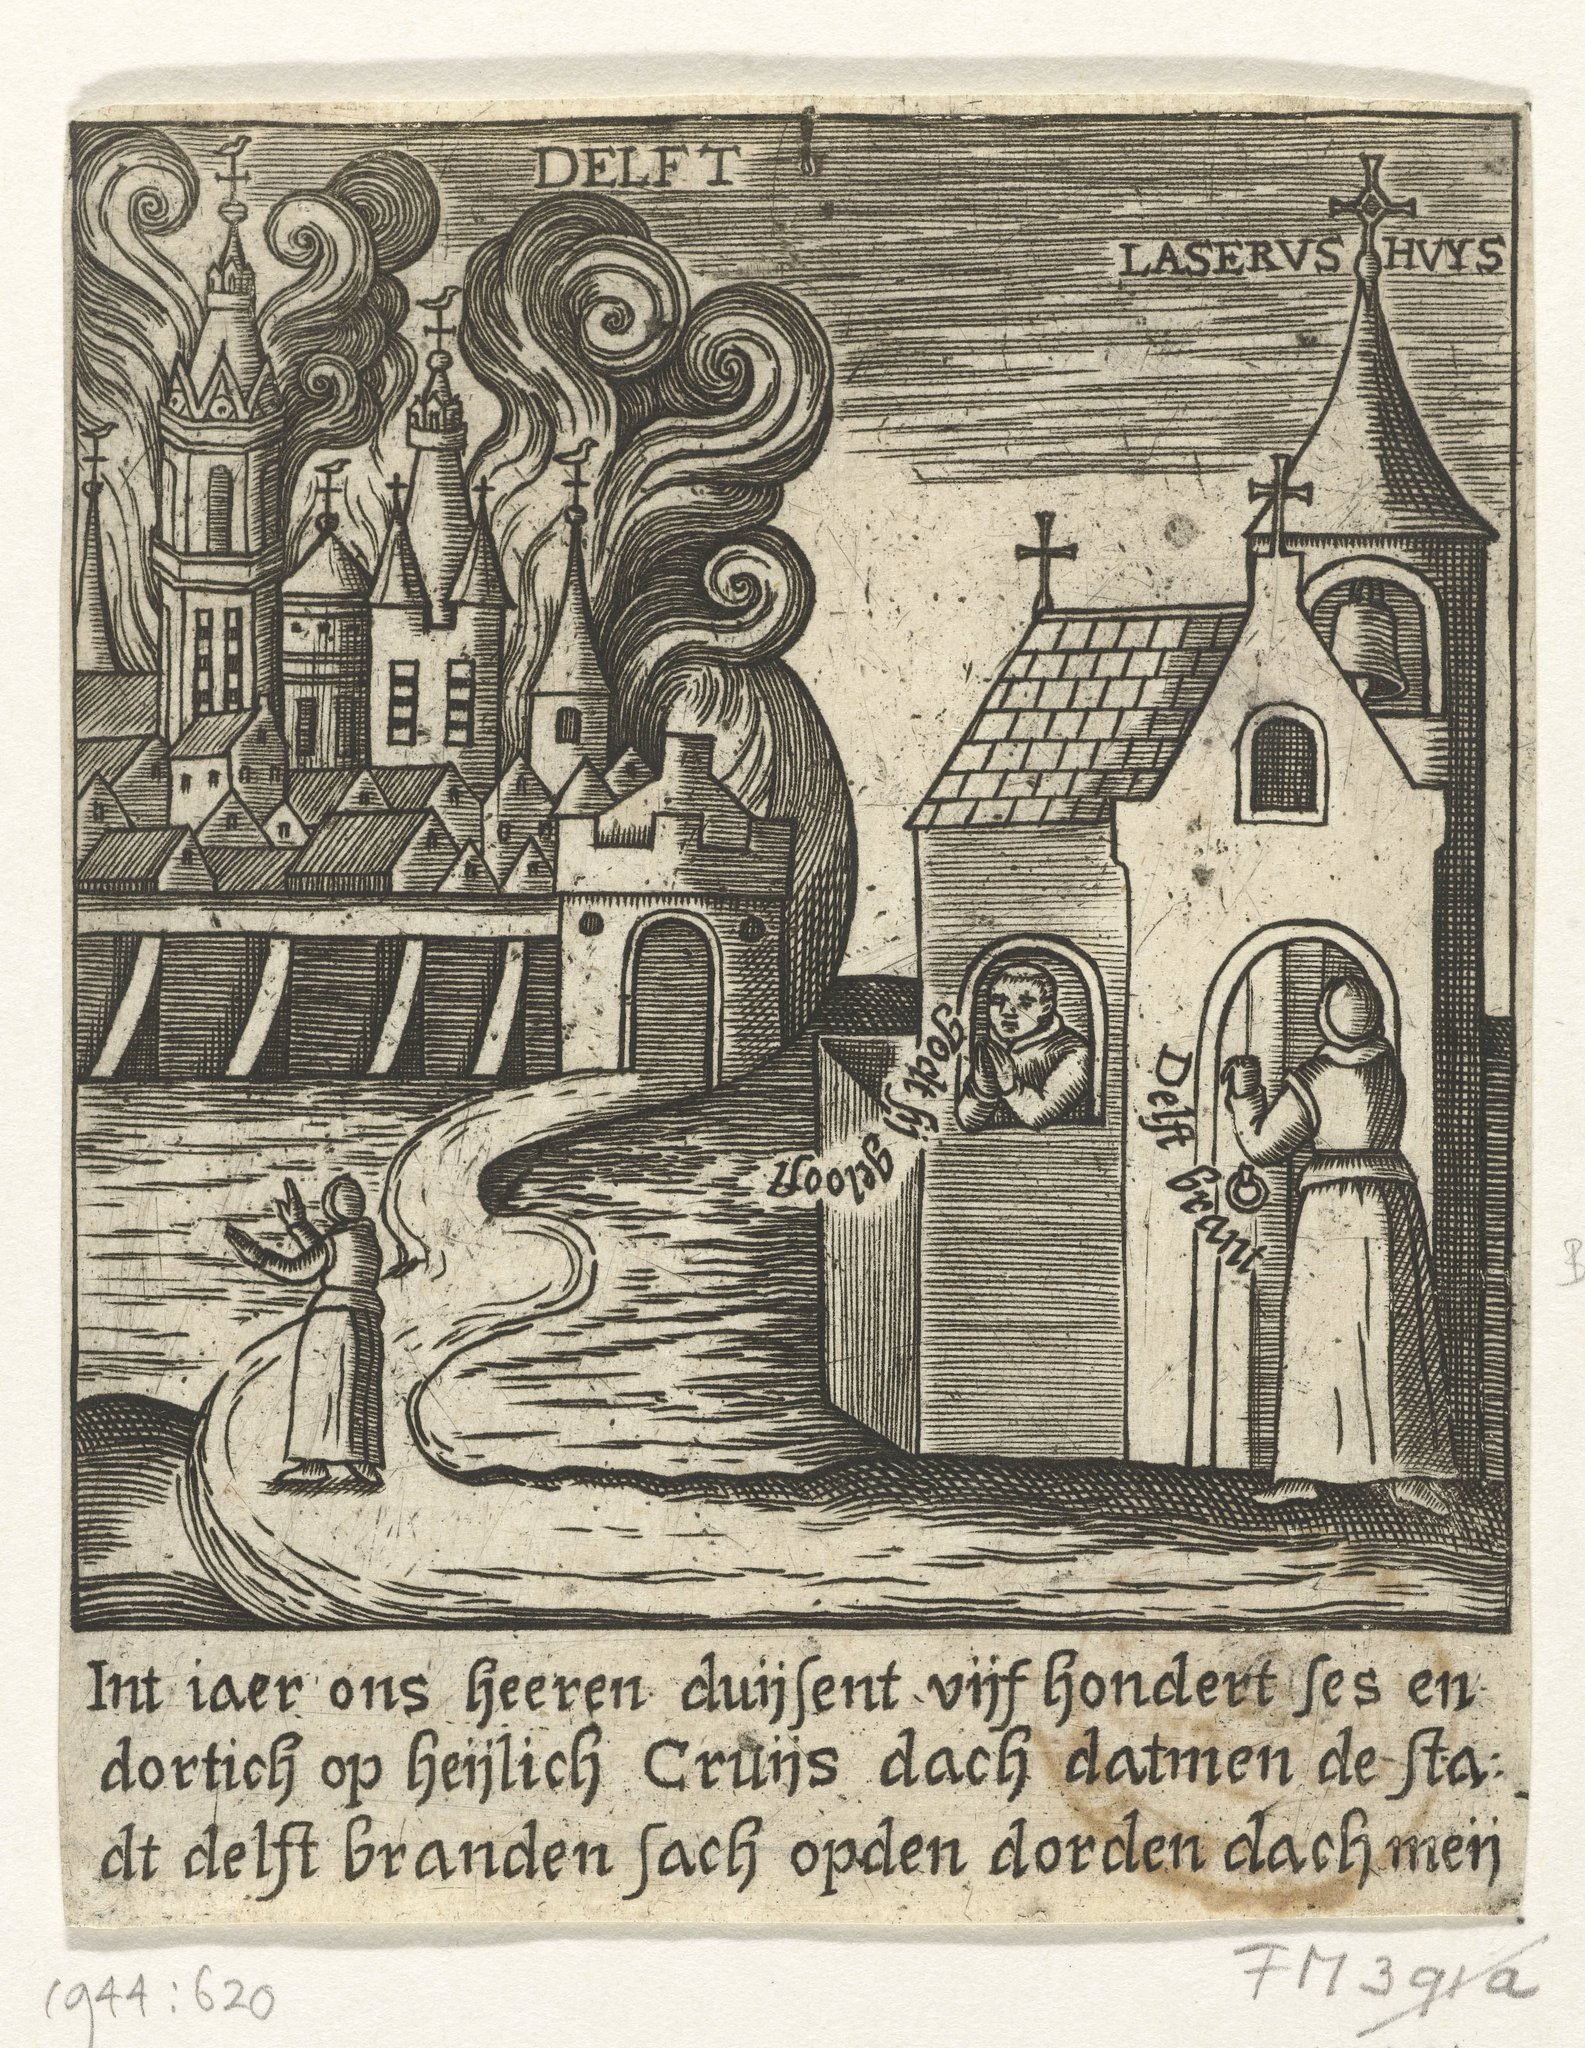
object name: print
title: Int iaer ons heeren duijsent vijf hondert ses en dortich (...) datmen de stadt delft branden sach opden dorden dach meij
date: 1536-1599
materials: paper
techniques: engraving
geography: northern netherlands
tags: on fire, ablaze, delft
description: Monniken in het Lazarushuis buiten de stad zien dat in de verte de stad Delft in brand staat, 3 mei 1536. Opschriften in de voorstelling en onderschrift van drie regels.